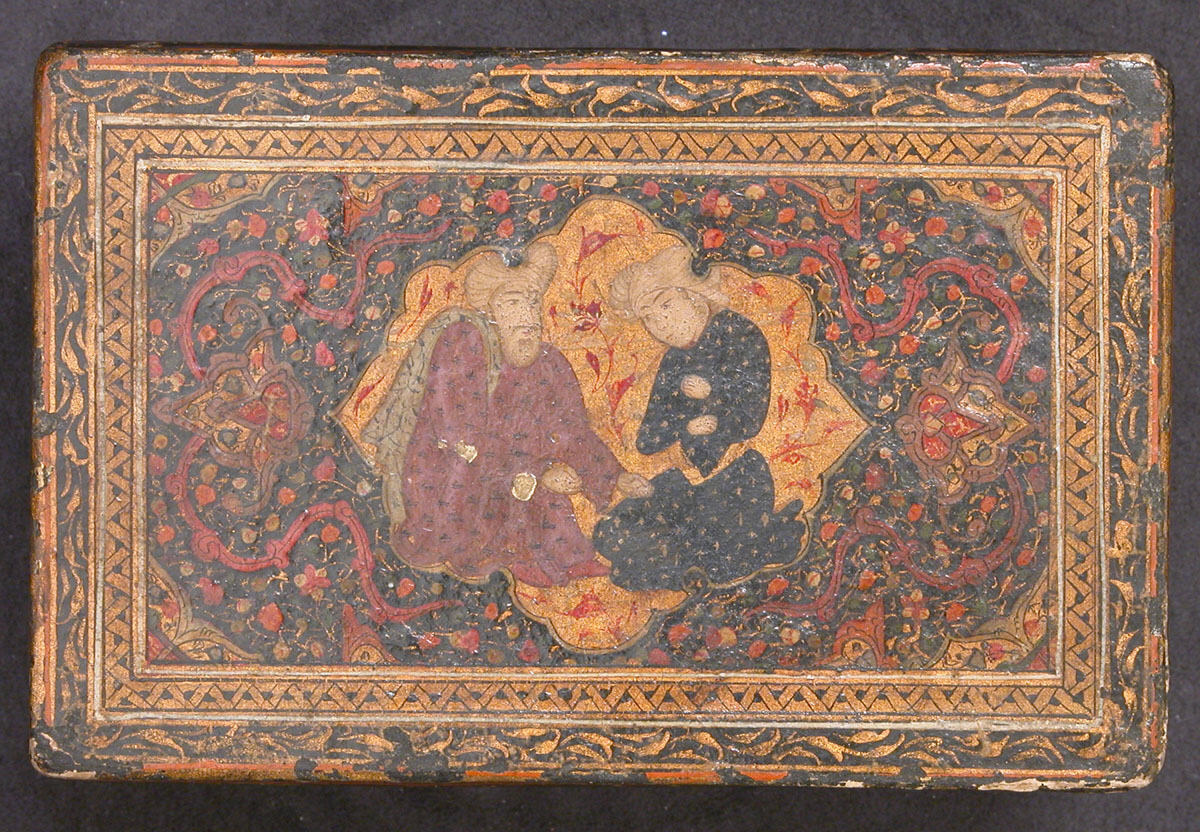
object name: box with lid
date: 1801-1900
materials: board, paste, varnish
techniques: lacquer, painting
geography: iran